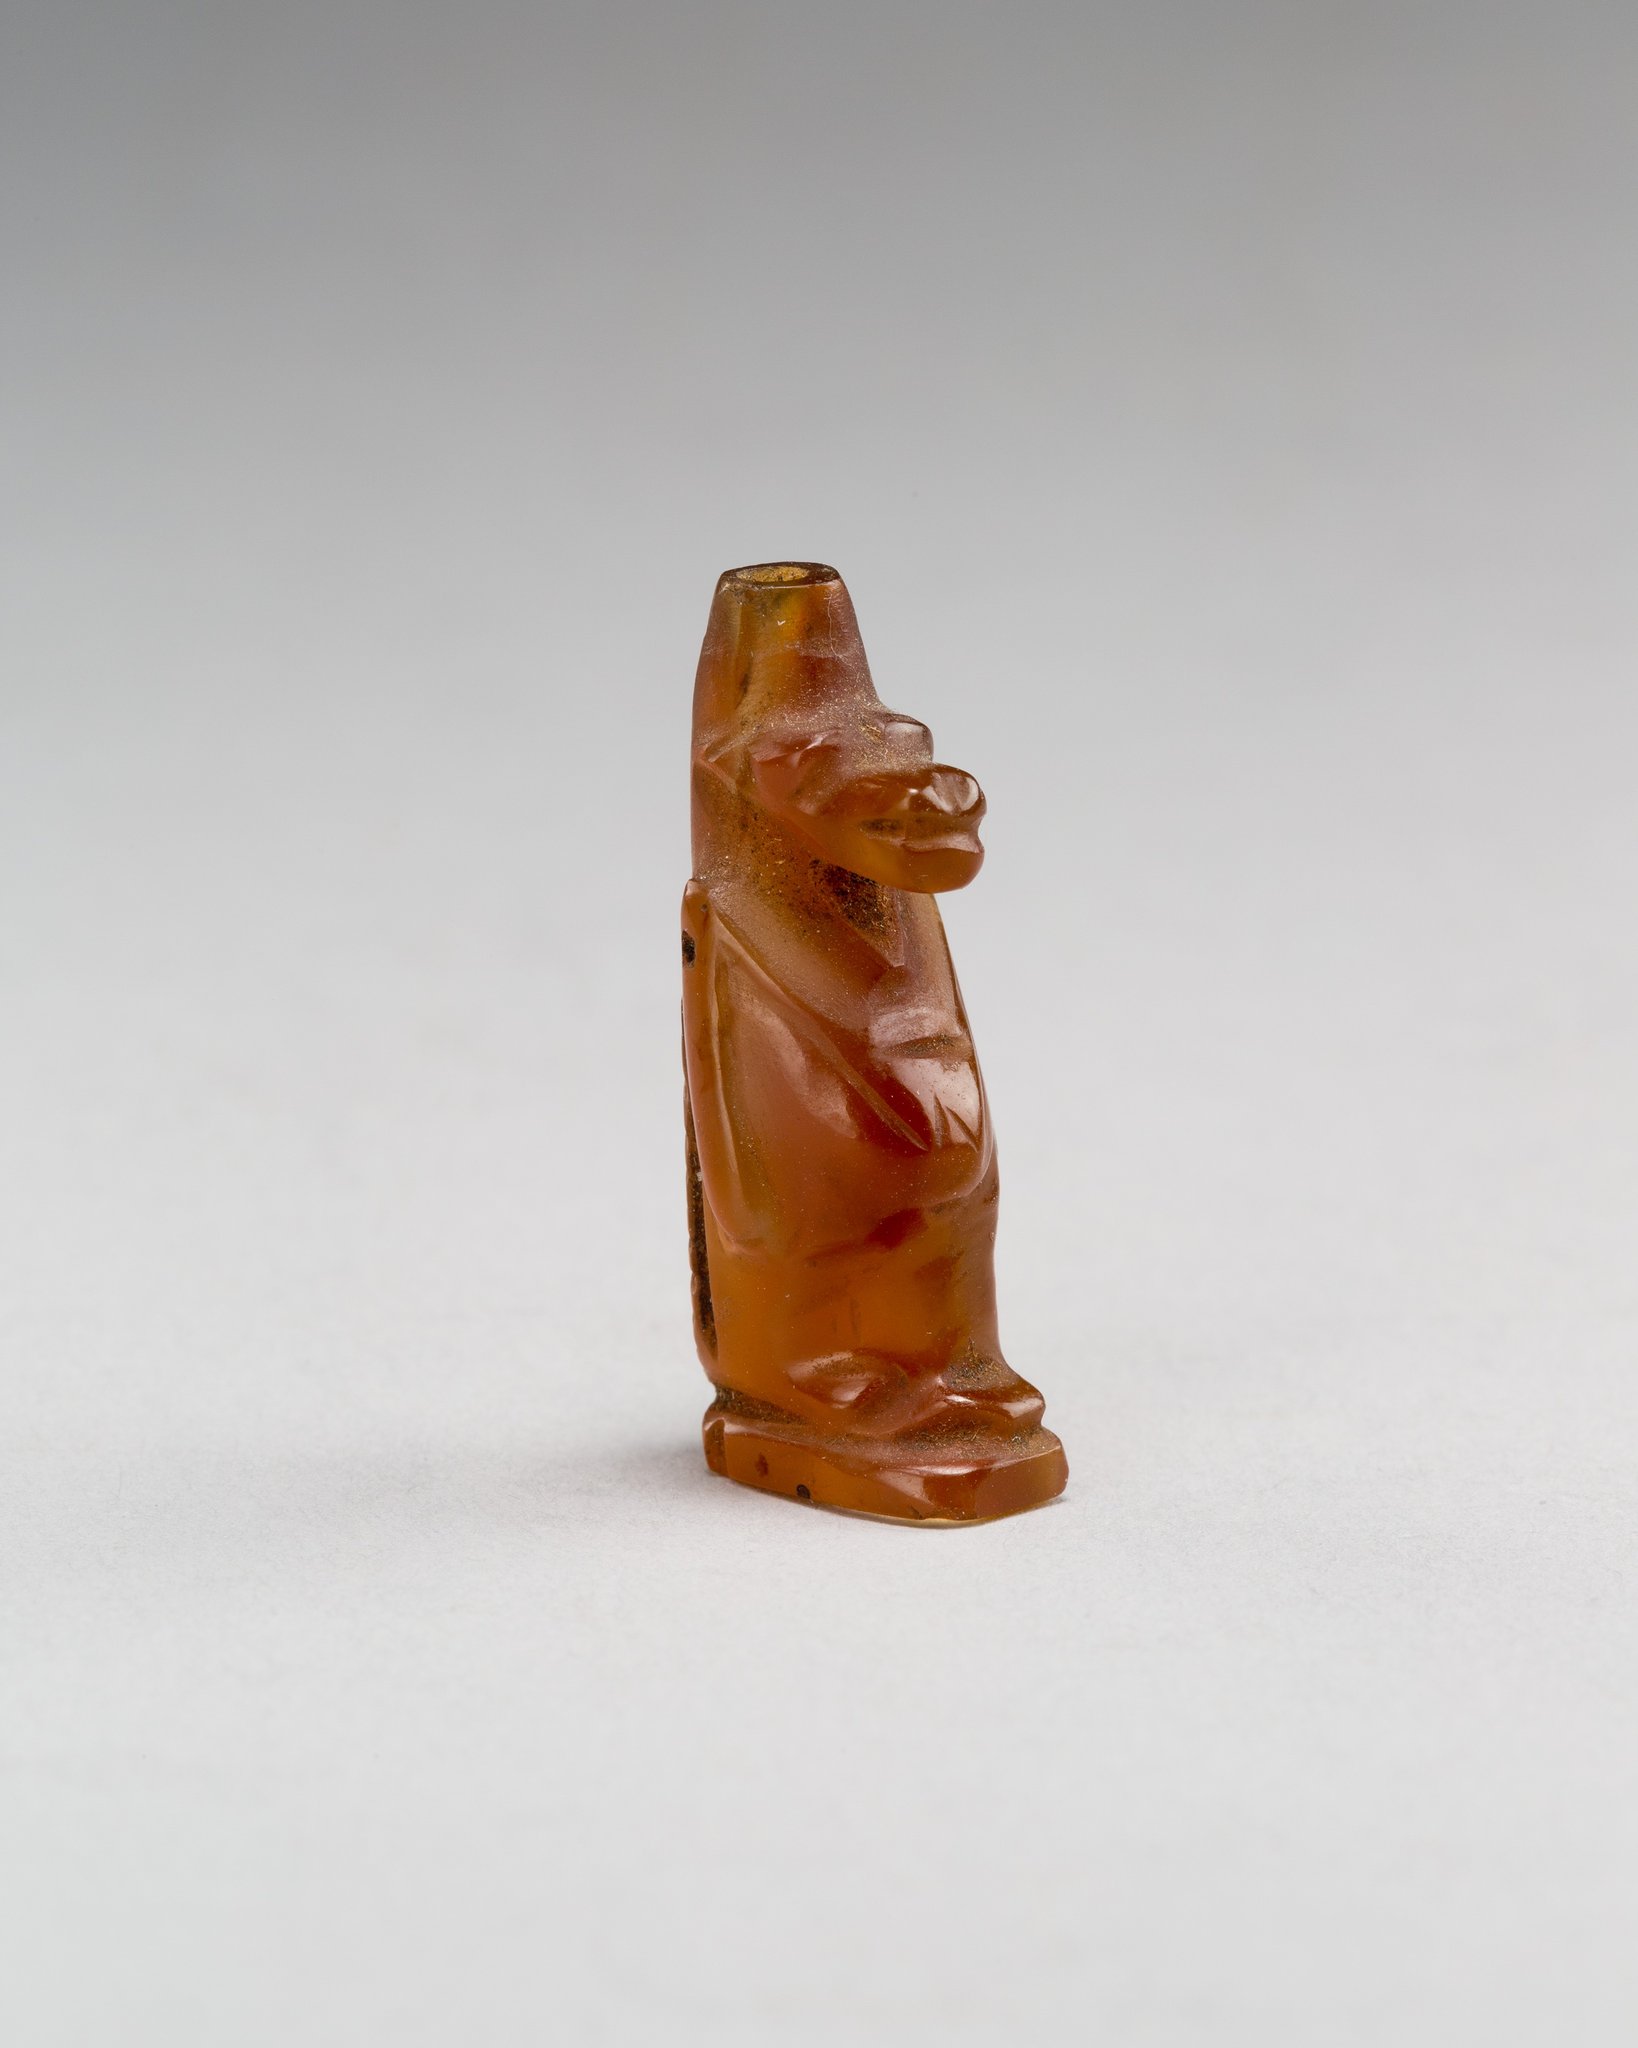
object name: amulet, taweret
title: Taweret amulet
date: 1550-1295 BCE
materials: gemstone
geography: egypt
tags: taweret